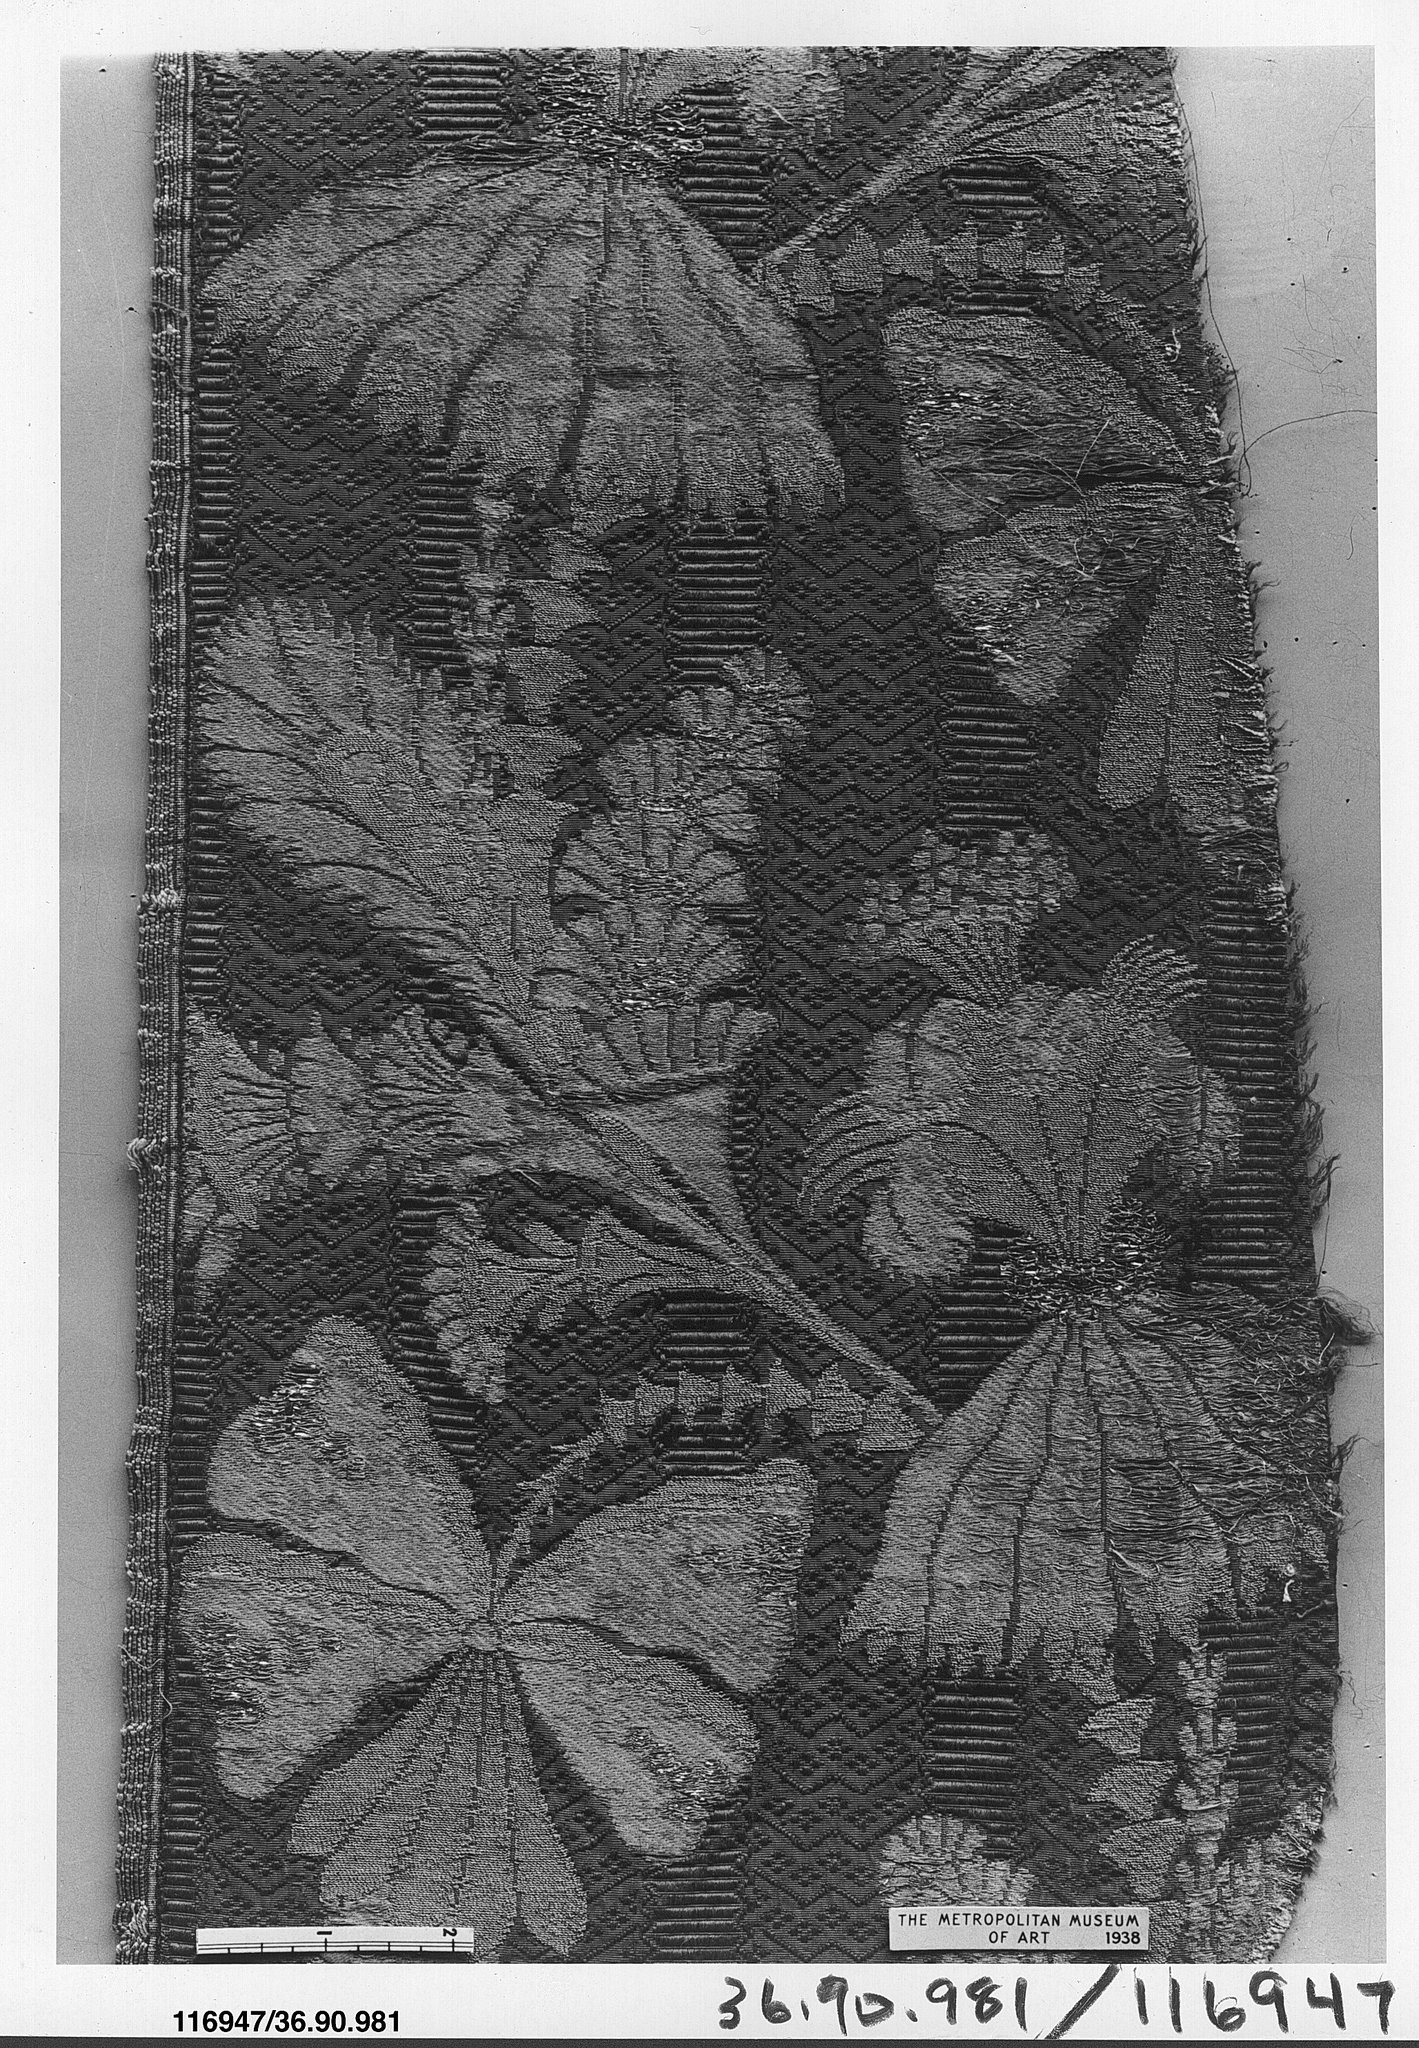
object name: piece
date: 1700-1715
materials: metal thread, silk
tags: flowers,leaves